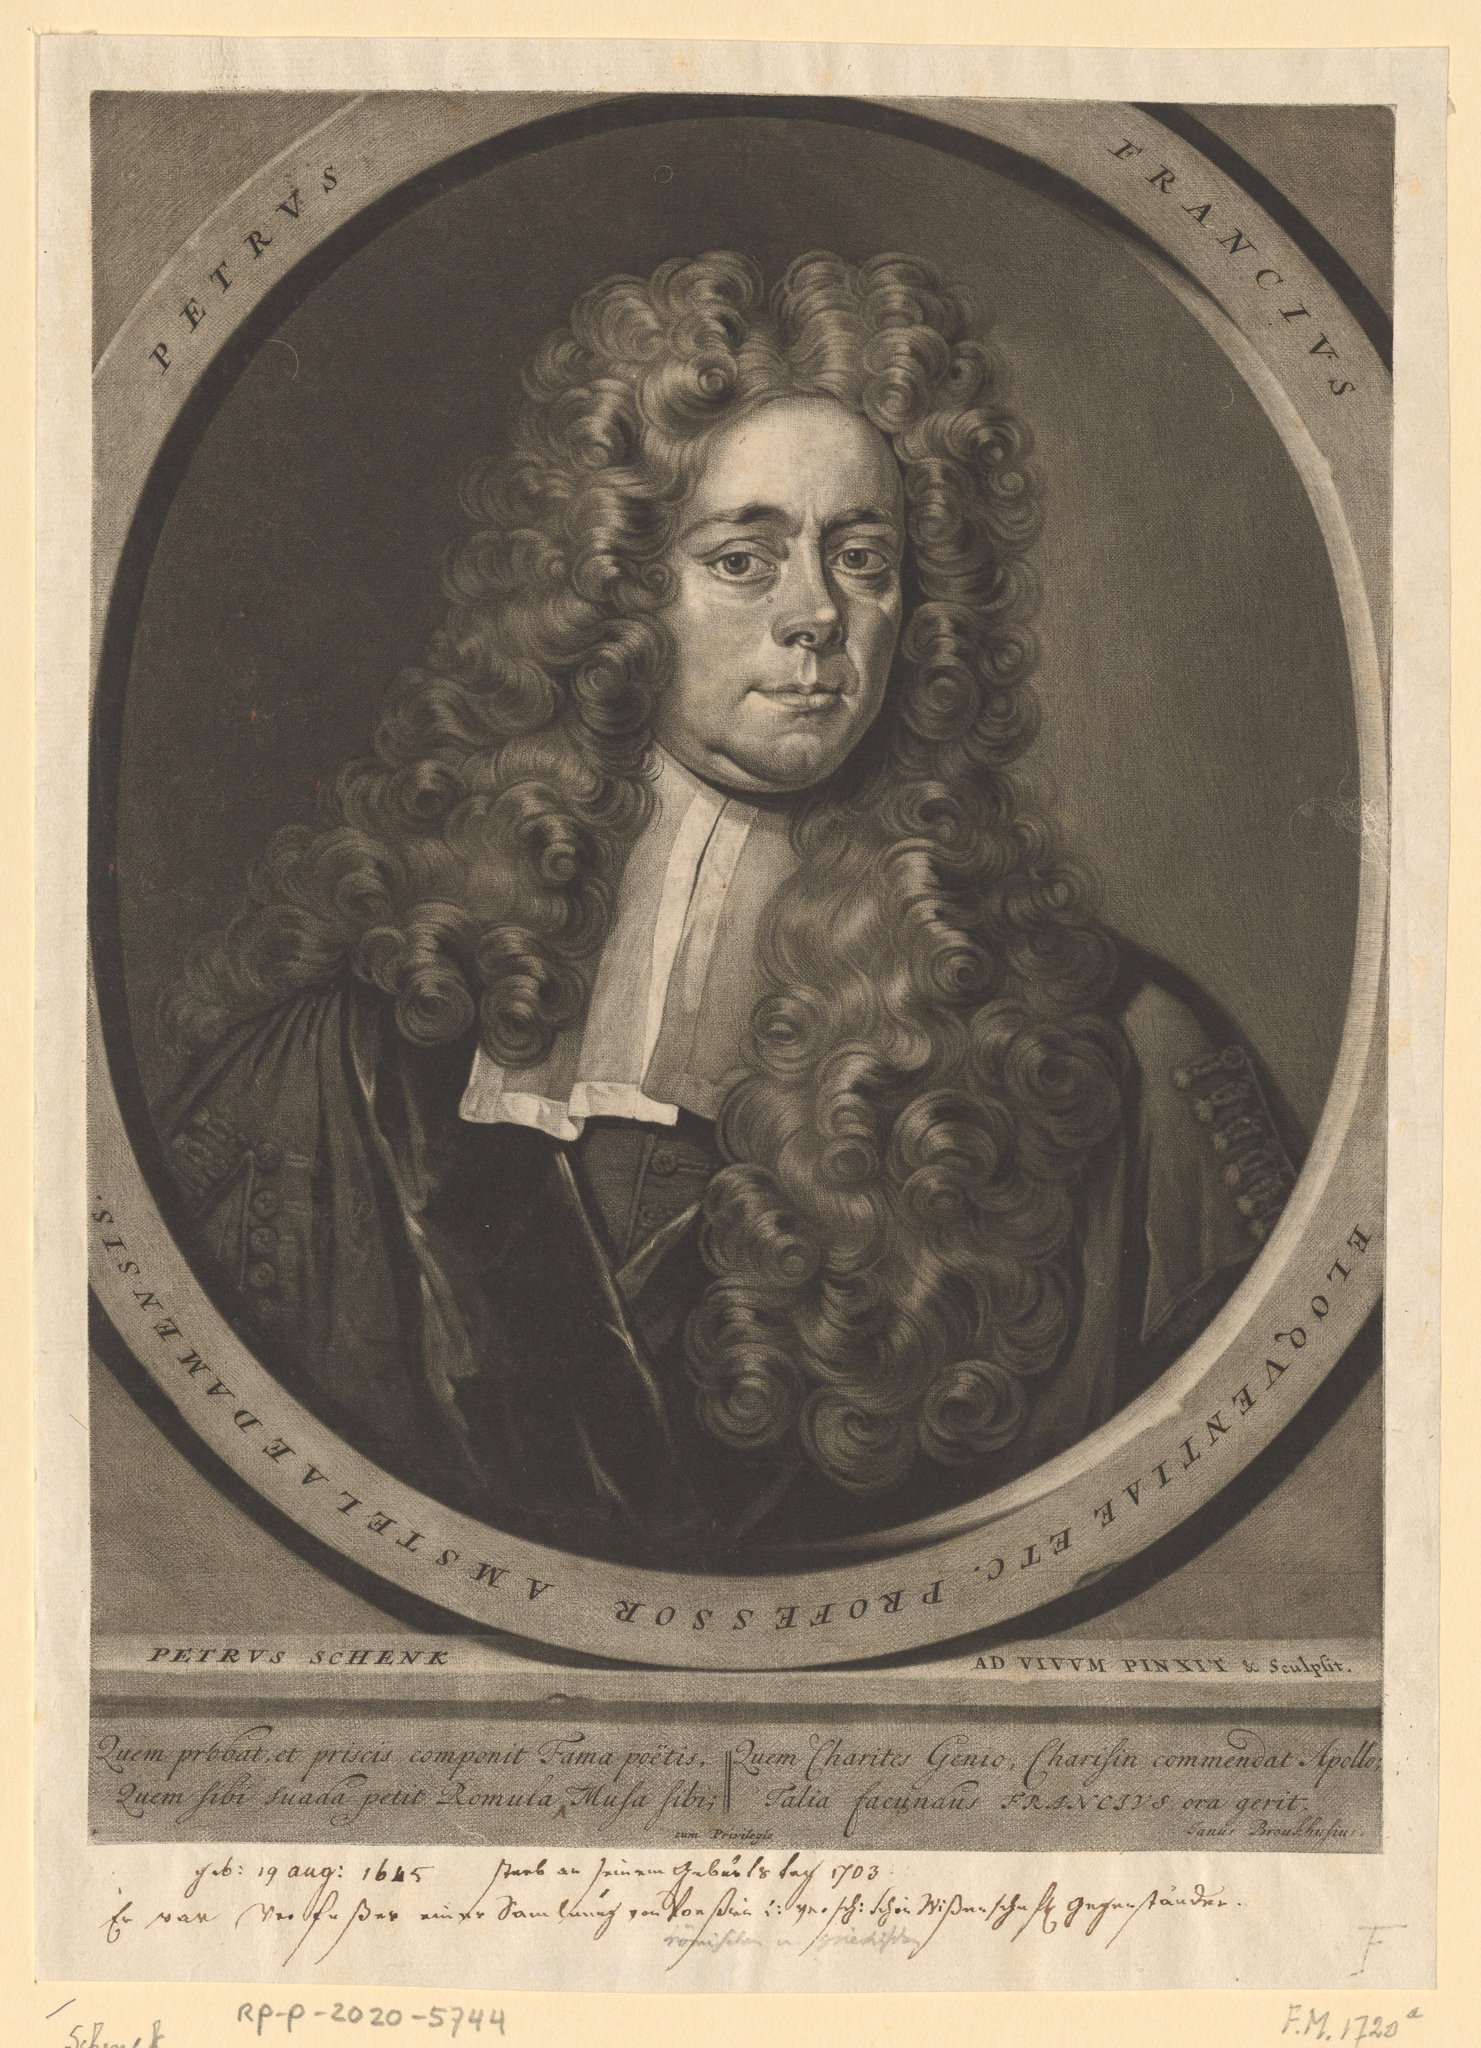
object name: print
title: Portret van Petrus Francius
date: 1674-1704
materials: paper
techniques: engraving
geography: amsterdam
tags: amsterdam, petrus francius, historical persons, wig, professor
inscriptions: collector's mark: Lugt 2228, collector's mark: Lugt 9, inscription: ‘geb: 19 aug: 1645 starb [...] seinem Geburtstag 1703./ [...]’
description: Met vierregelig vers in het Latijn onder het portret.